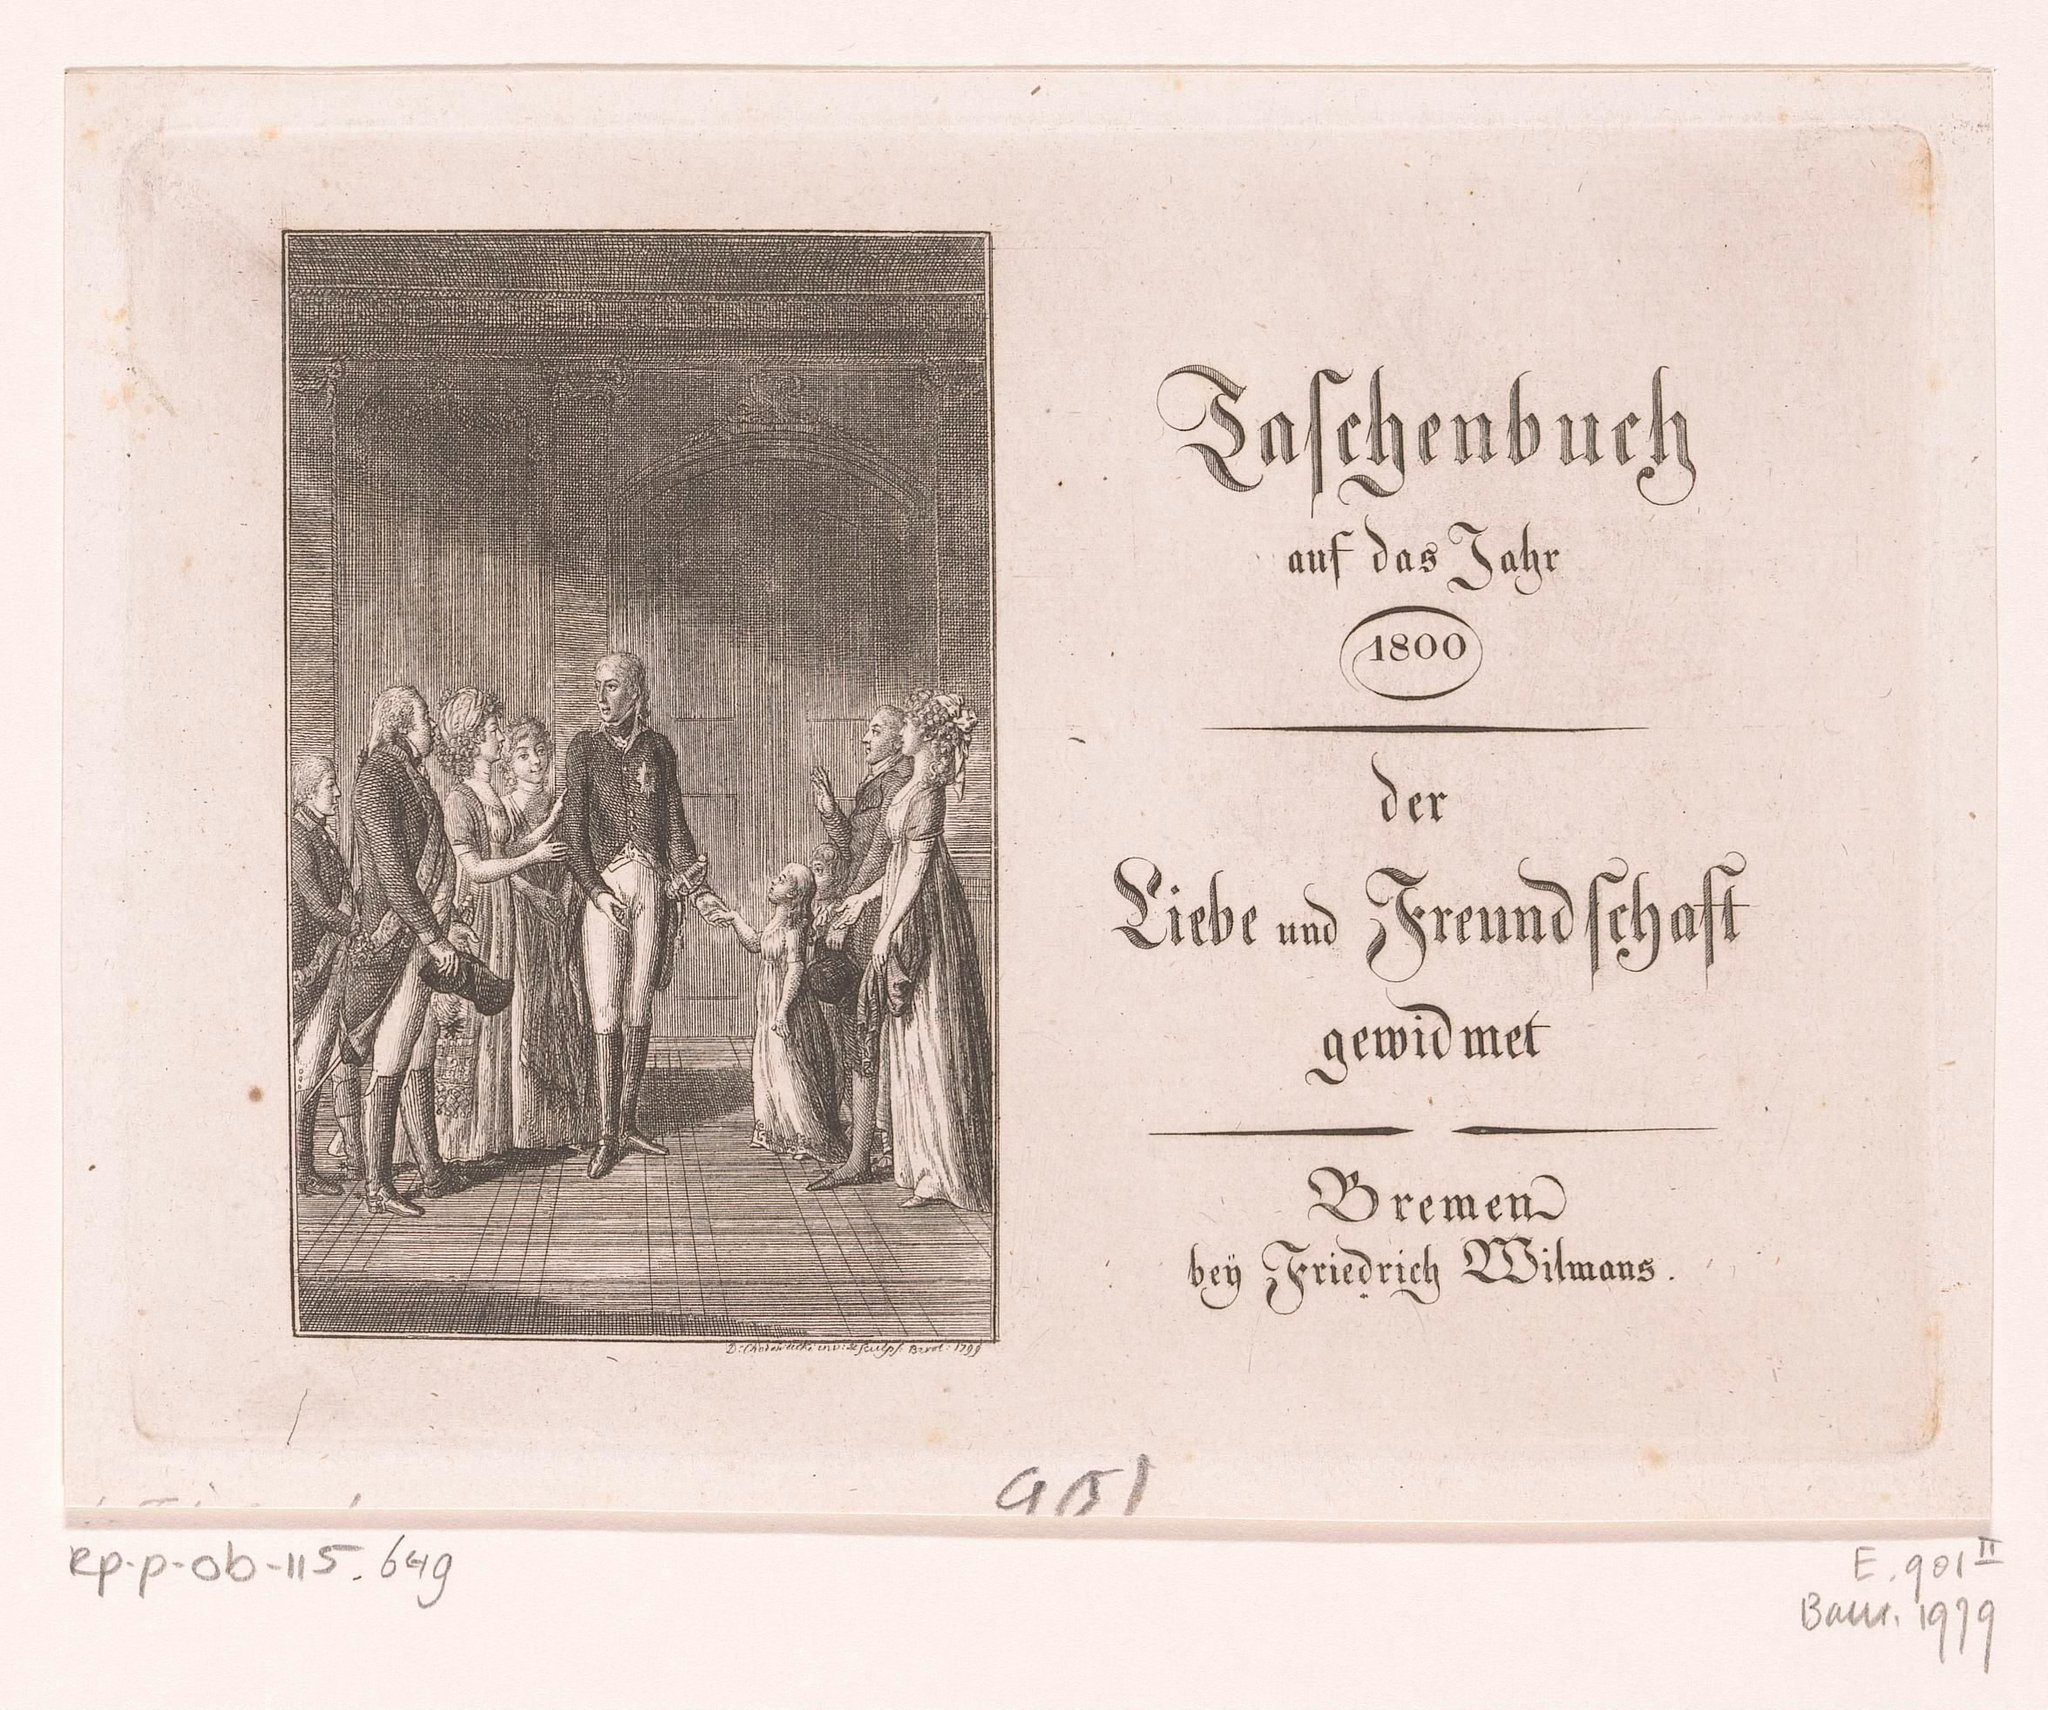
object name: titelblad, titelpagina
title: Titelpagina voor: Taschenbuch auf das Jahr 1800 der Liebe und Freundschaft gewidmet, 1799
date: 1799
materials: paper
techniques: etching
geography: berlin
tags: berlin, frederik willem iii koning van pruisen, royal bastards, family, descendance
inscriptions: collector's mark: Lugt 2228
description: Titelpagina voor: Taschenbuch auf das Jahr 1800 der Liebe und Freundschaft gewidmet. Bremen: Friedrich Wilmans, [1799].